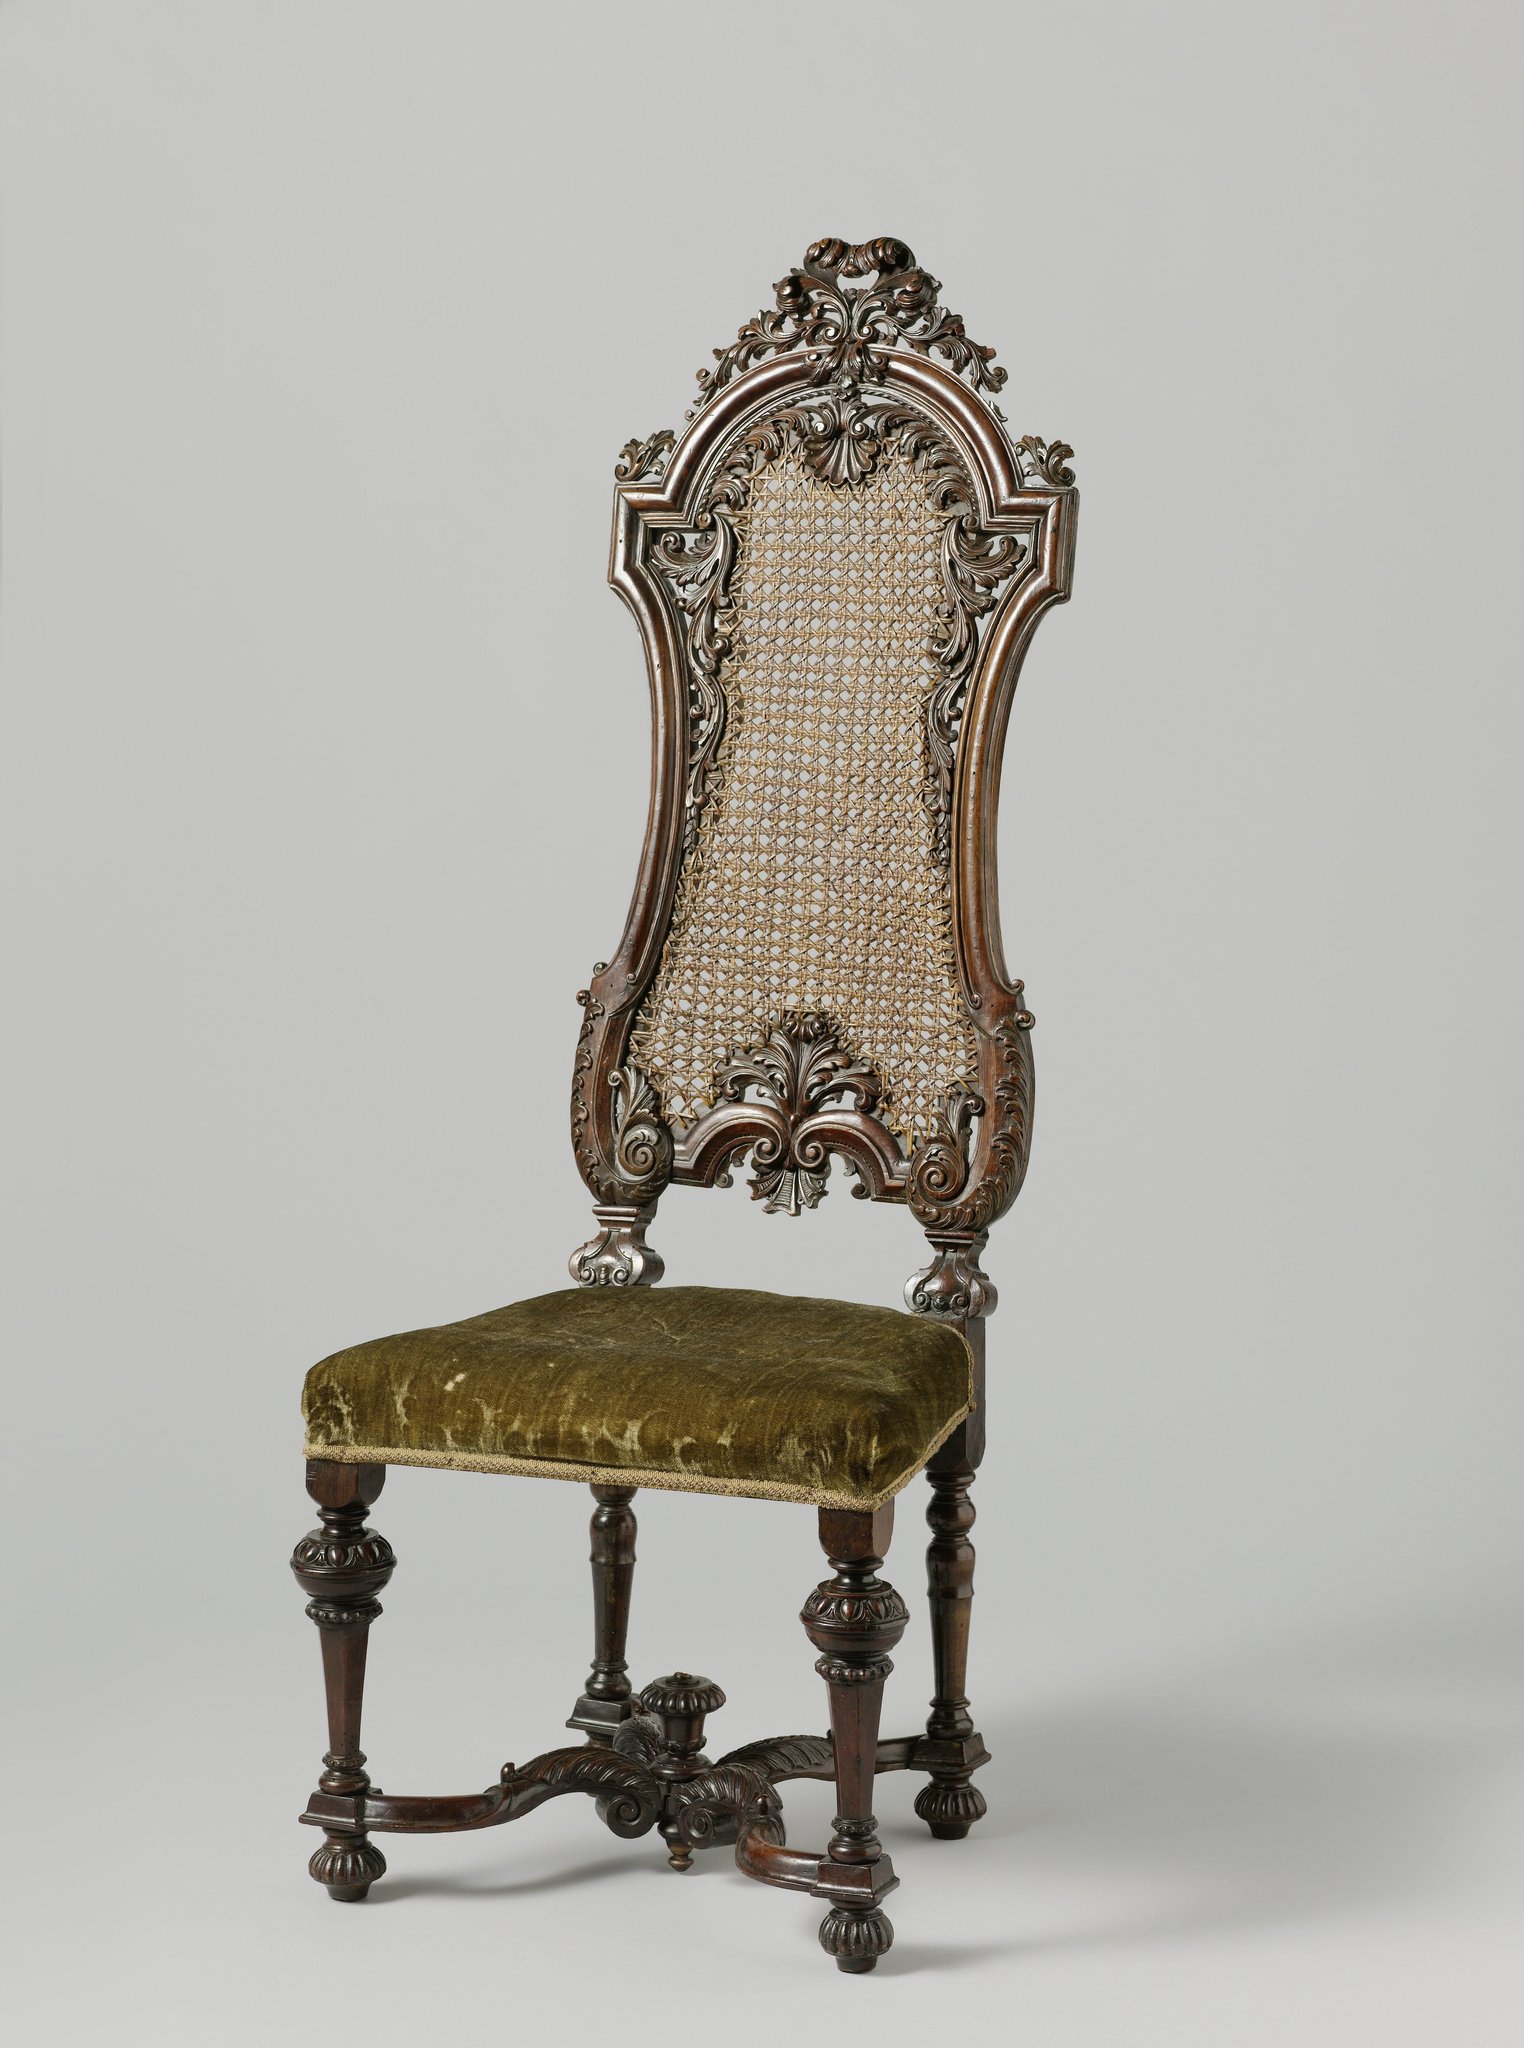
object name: furniture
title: Stoel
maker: Anonymous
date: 1700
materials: wood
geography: northern netherlands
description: Stoel van notenhout. Het meubel heeft een met gebloemd bronskleurige trijp beklede zitting en een met riet bespannen rug. Het rust op balustervormige poten met bolvoeten. Op het kruispunt van het geslingerde kruis staat een vaasje. De hoge rug heeft een geprofileerd raam met een halfcirkelvormige, uitgeschulpte bovendorpel, binnenwaarts gewelfde stijlen en een onderdorpel met voluten en schelp. Binnen dit raam acanthusblad en schelpmotief. Het raam wordt bekroond door een acanthusbladversiering.